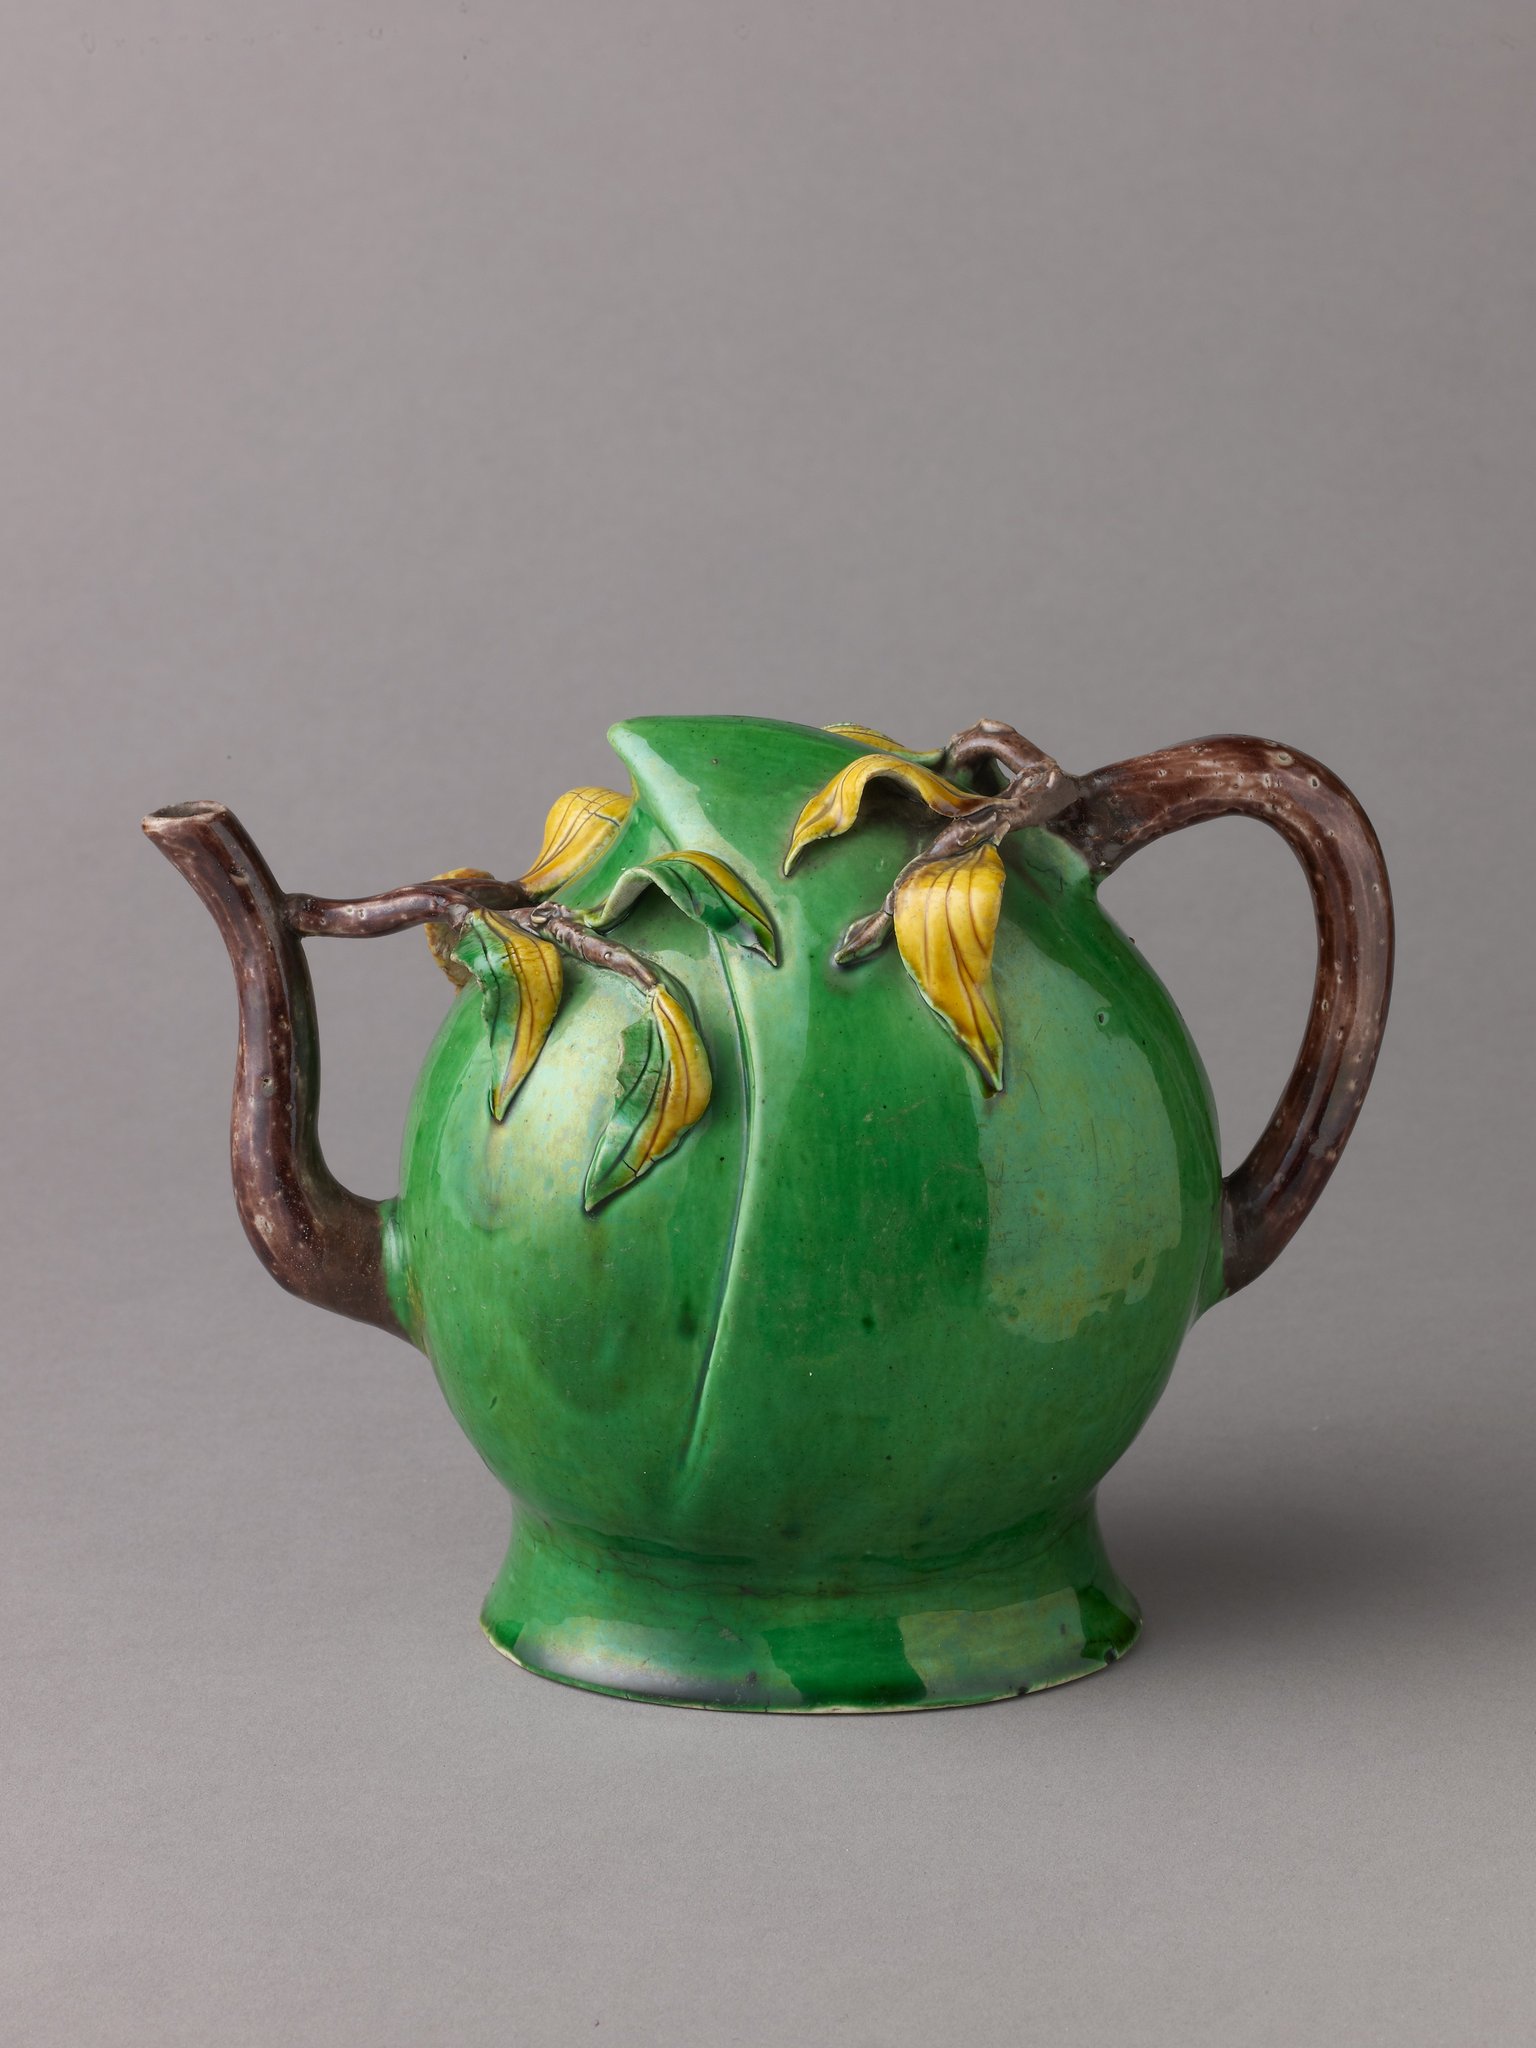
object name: winepot or teapot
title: Peach-Shaped Wine Pot or Tea Pot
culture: chinese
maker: chinese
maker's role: artist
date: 1644-1683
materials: glaze, porcelain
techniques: polychrome, relief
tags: leaves